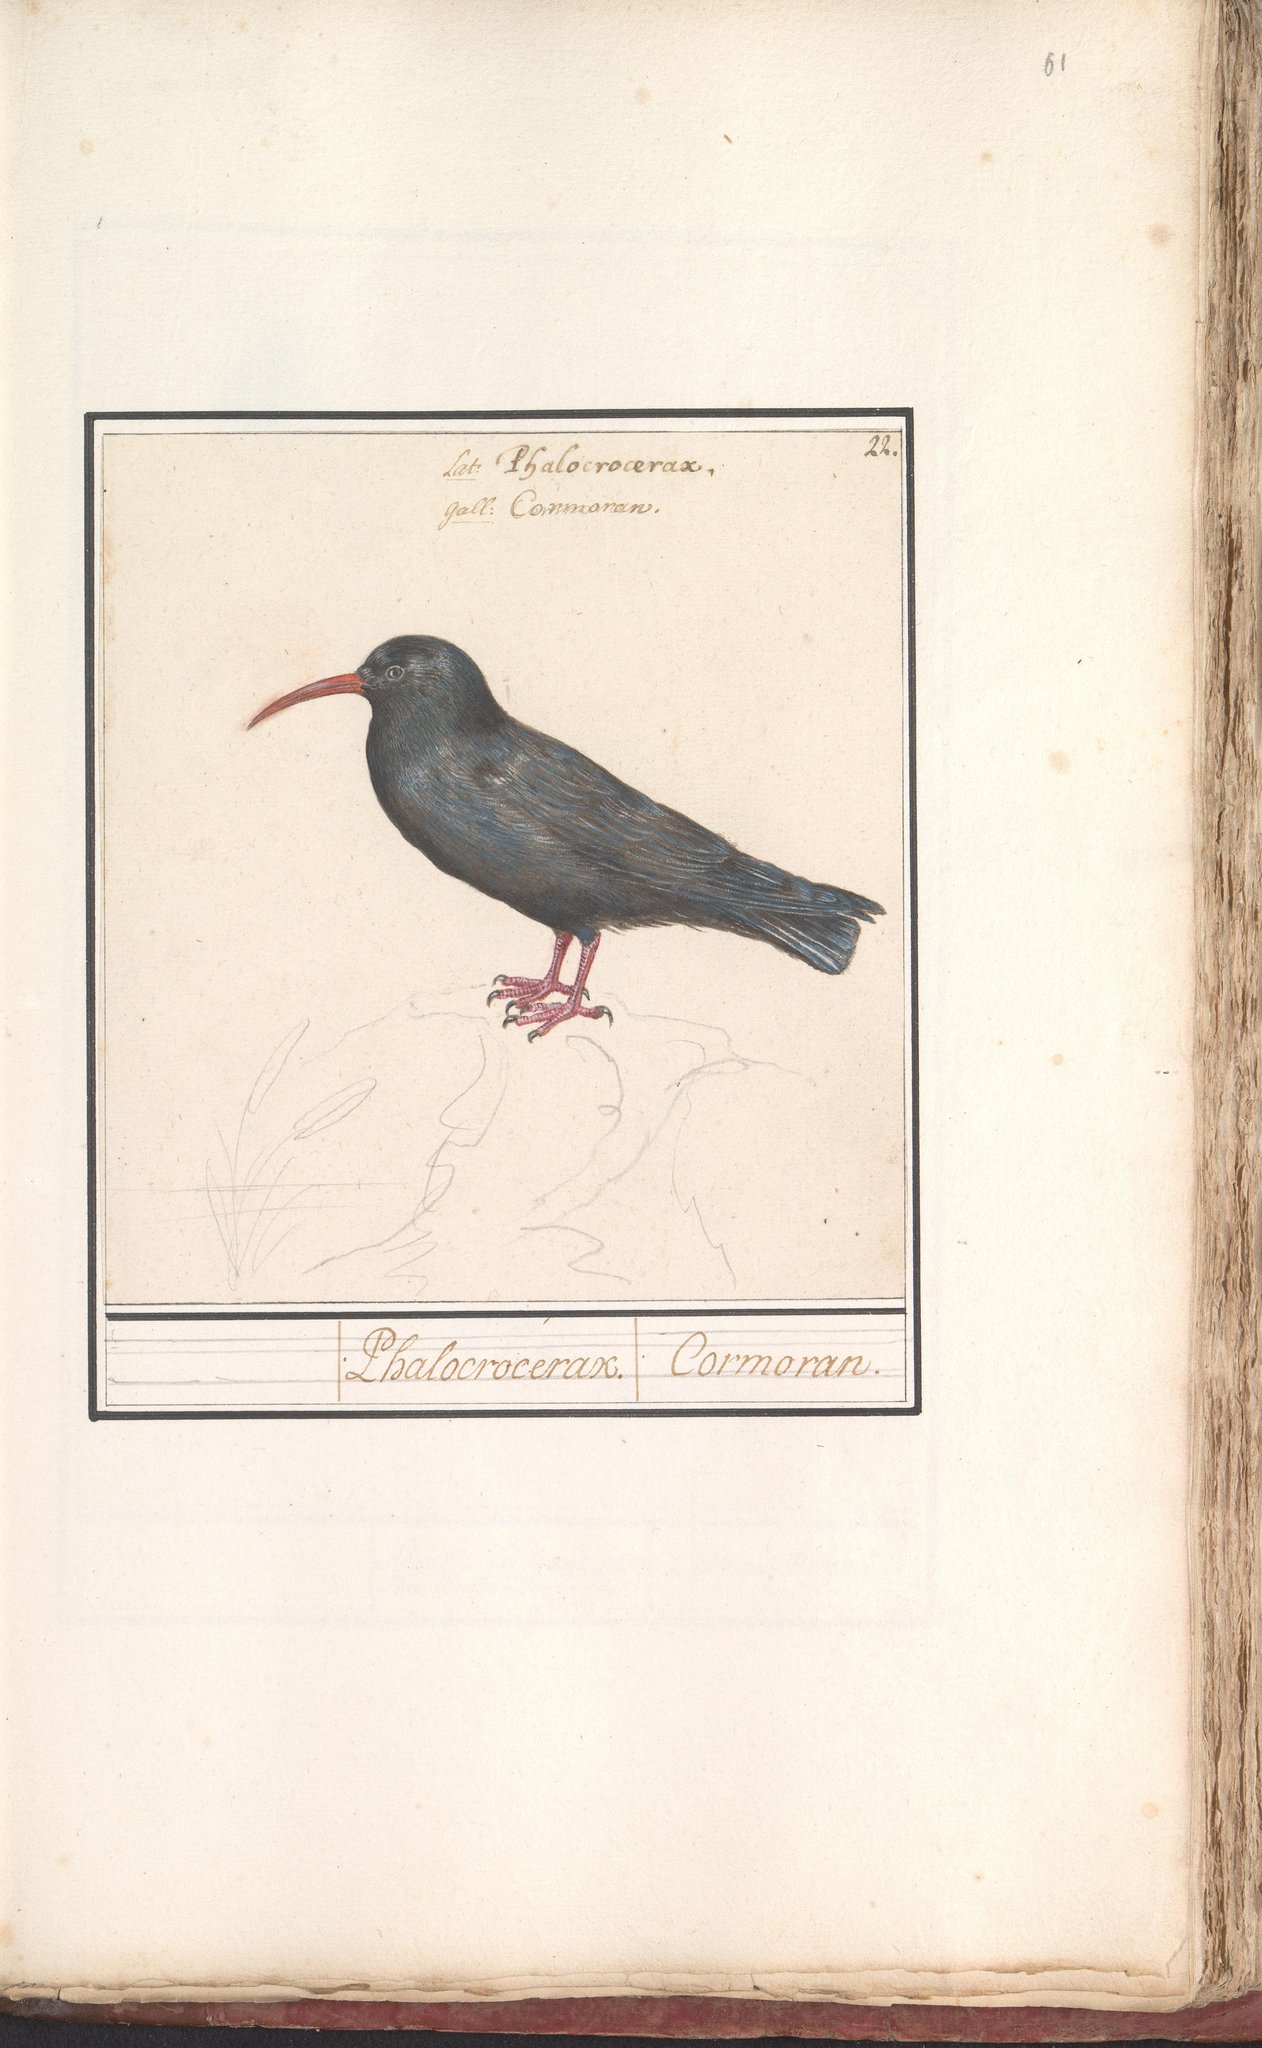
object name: drawing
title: Alpenkraai (Pyrrhocorax pyrrhocorax)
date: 1596-1610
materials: chalk, paint, ink, paper, pencil, watercolor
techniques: brush, pen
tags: song-birds: red-billed chough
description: Alpenkraai. Genummerd rechtsboven: 22. Bovenaan de Latijnse en Franse naam. Onderdeel van het derde album met tekeningen van vogels. Vijfde van twaalf albums met tekeningen van dieren, vogels en planten bekend rond 1600, gemaakt in opdracht van keizer Rudolf II. Met toelichting in Nederlands, Latijn en Frans.